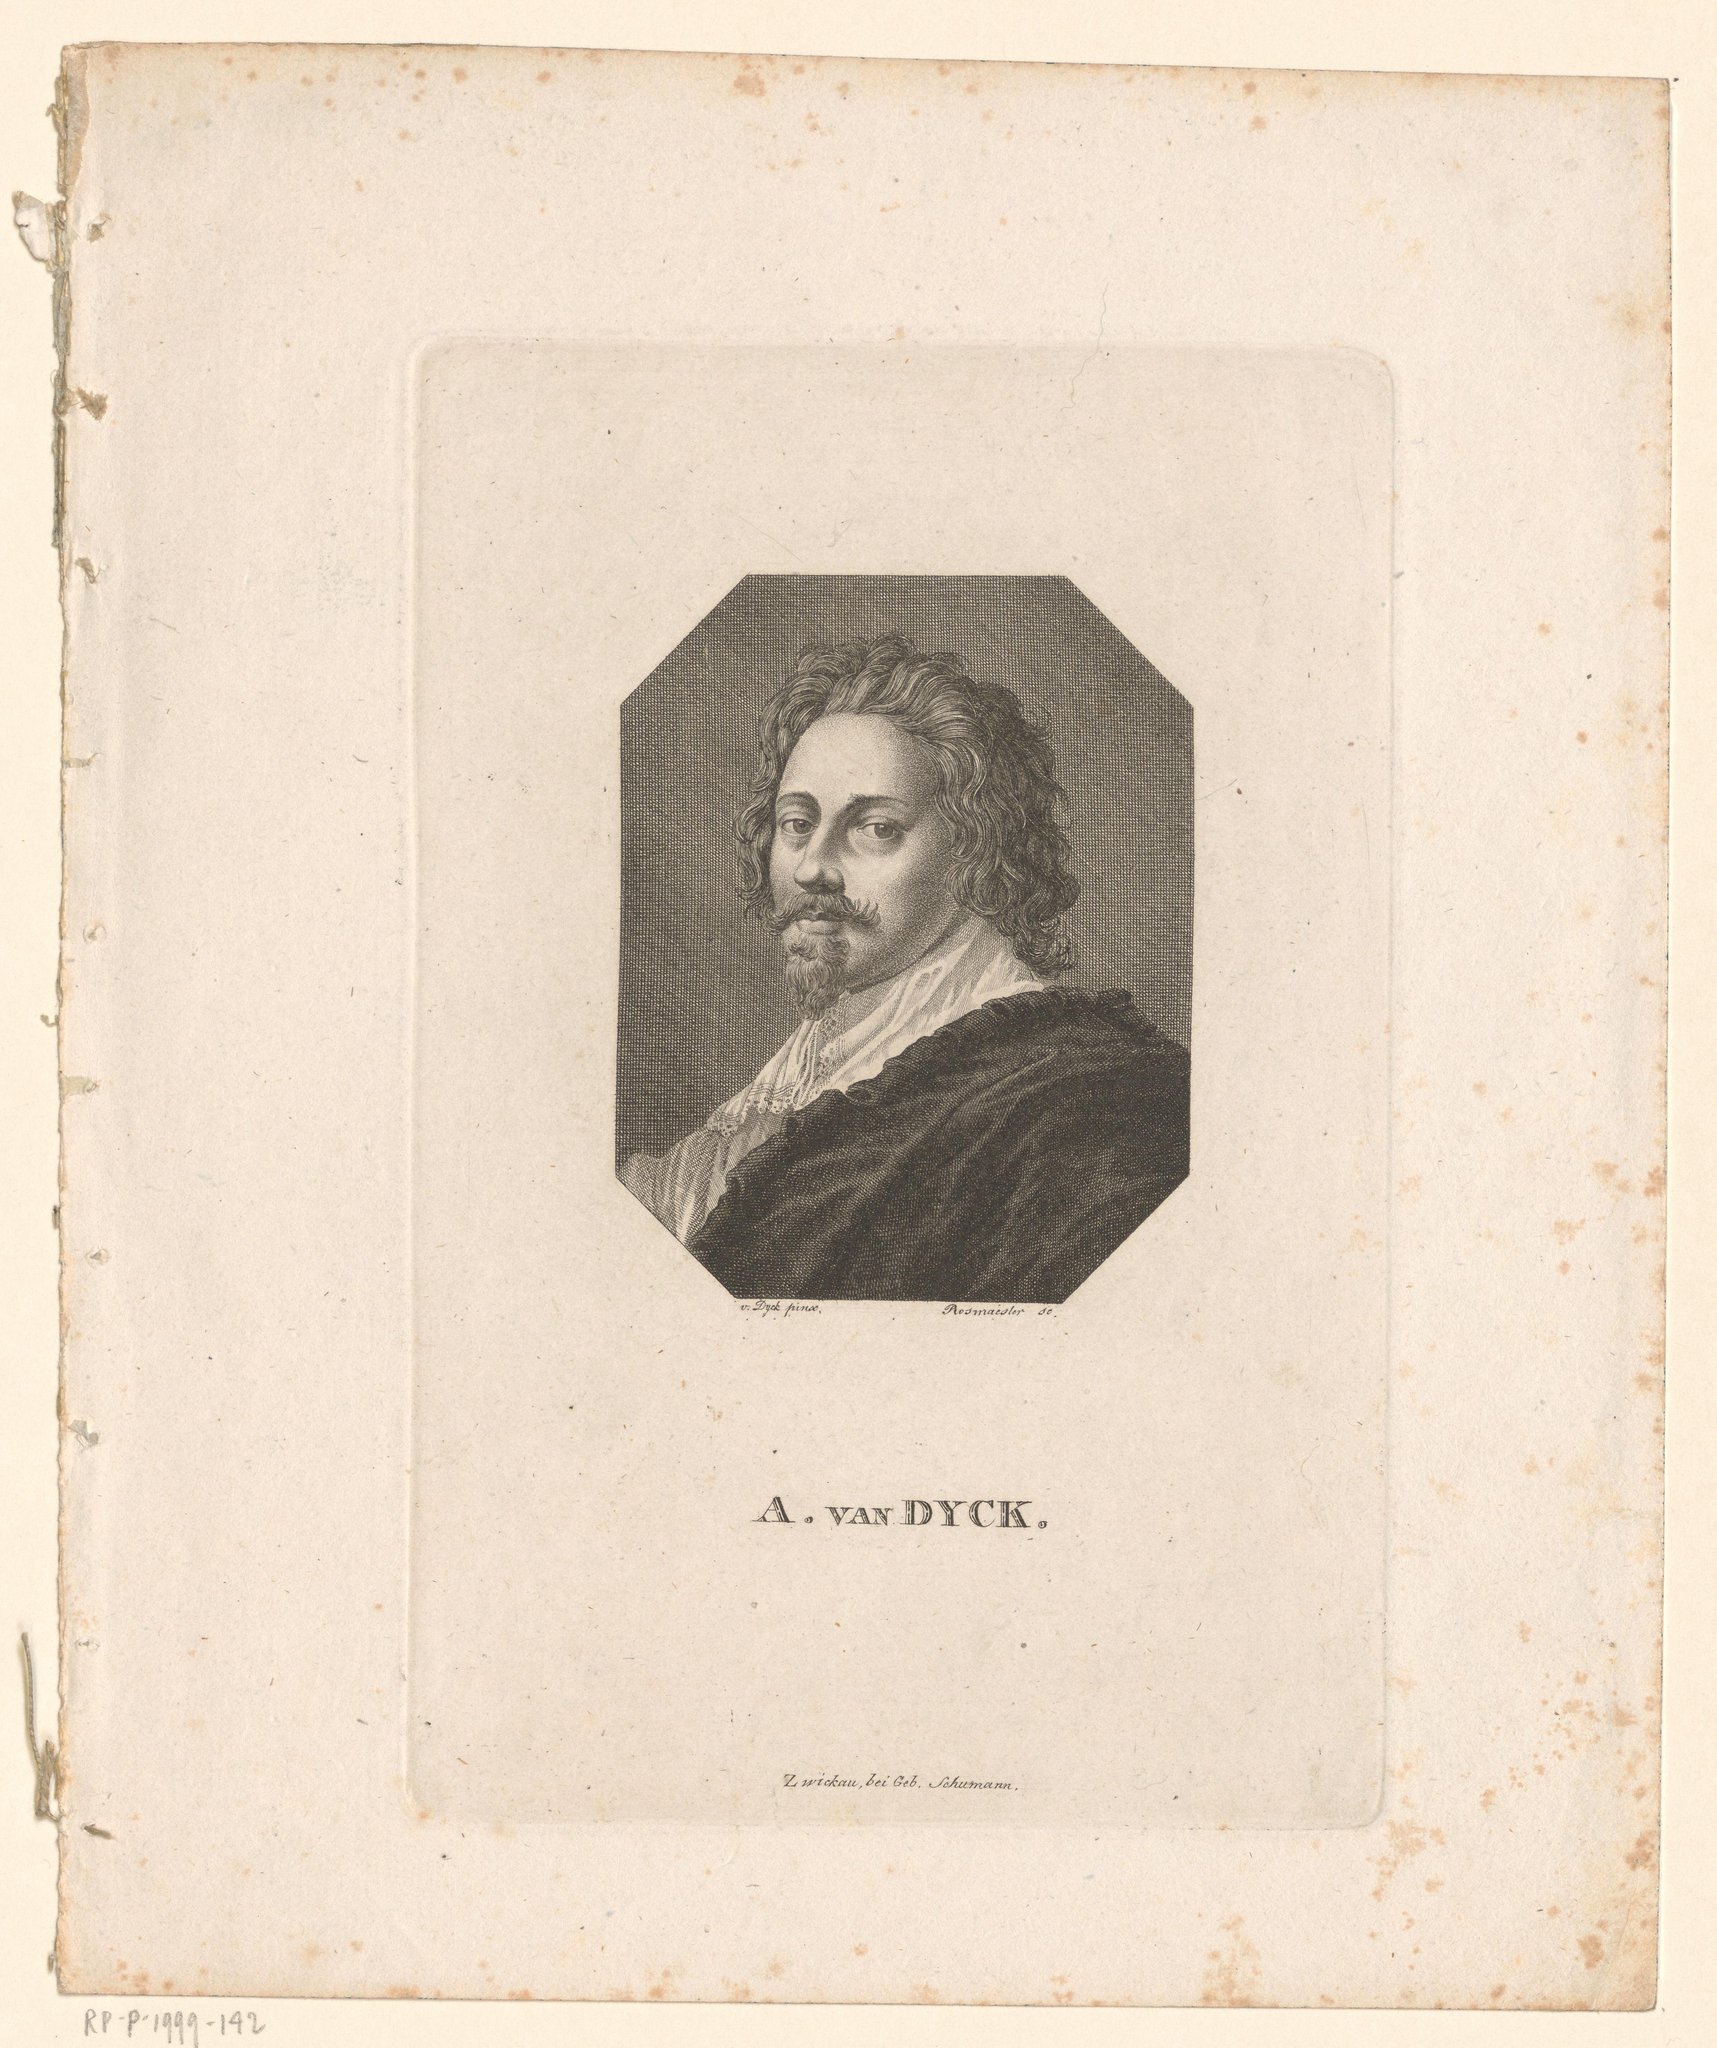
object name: print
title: Portretten van beroemde mensen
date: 1818-1832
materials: paper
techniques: etching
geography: germany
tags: antwerp, painter, draughtsman, anthony van dyck, historical persons, portrait, self-portrait of painter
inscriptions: collector's mark: Lugt 2228, collector's mark: Lugt 2760